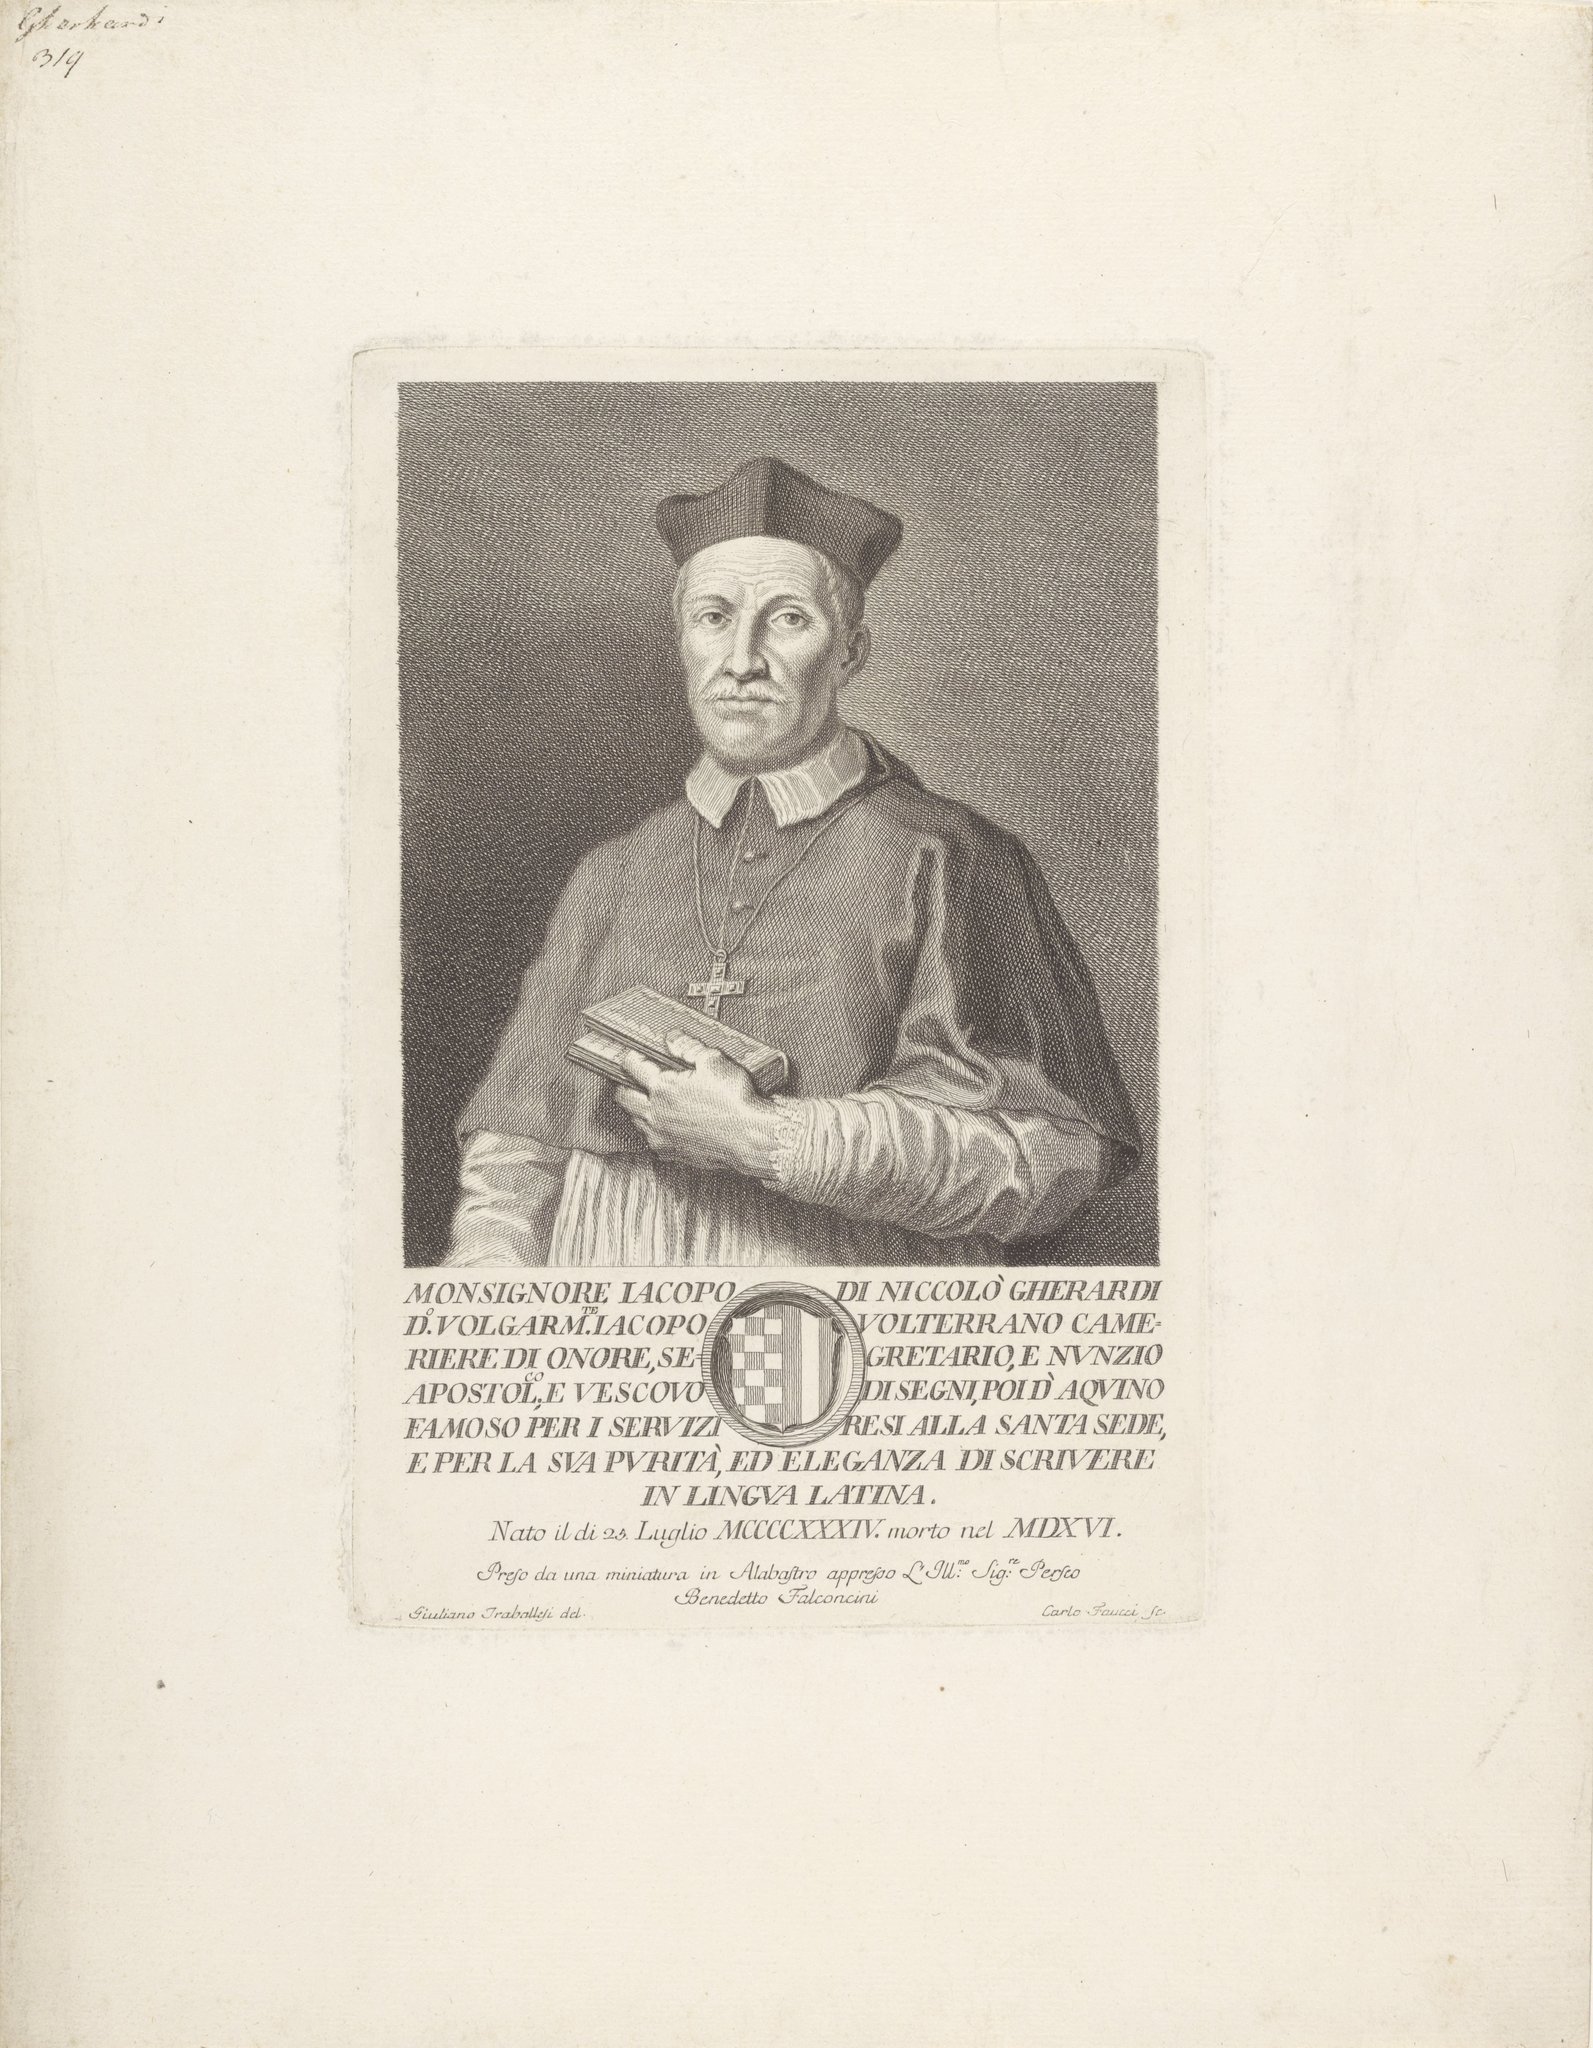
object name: print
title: Portret van Jacopo Gherardi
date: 1739-1784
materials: paper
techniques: etching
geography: italy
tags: clergyman, historical persons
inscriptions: collector's mark: Lugt 2228, inscription: ‘Gherardi / 319’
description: Deze prent maakt deel uit van een reeks portretprenten van onbekende omvang. De prenten zijn gemaakt door meedere prentmakers, onder wie Francesco Allegrini en Carlo en Raimondo Faucci.